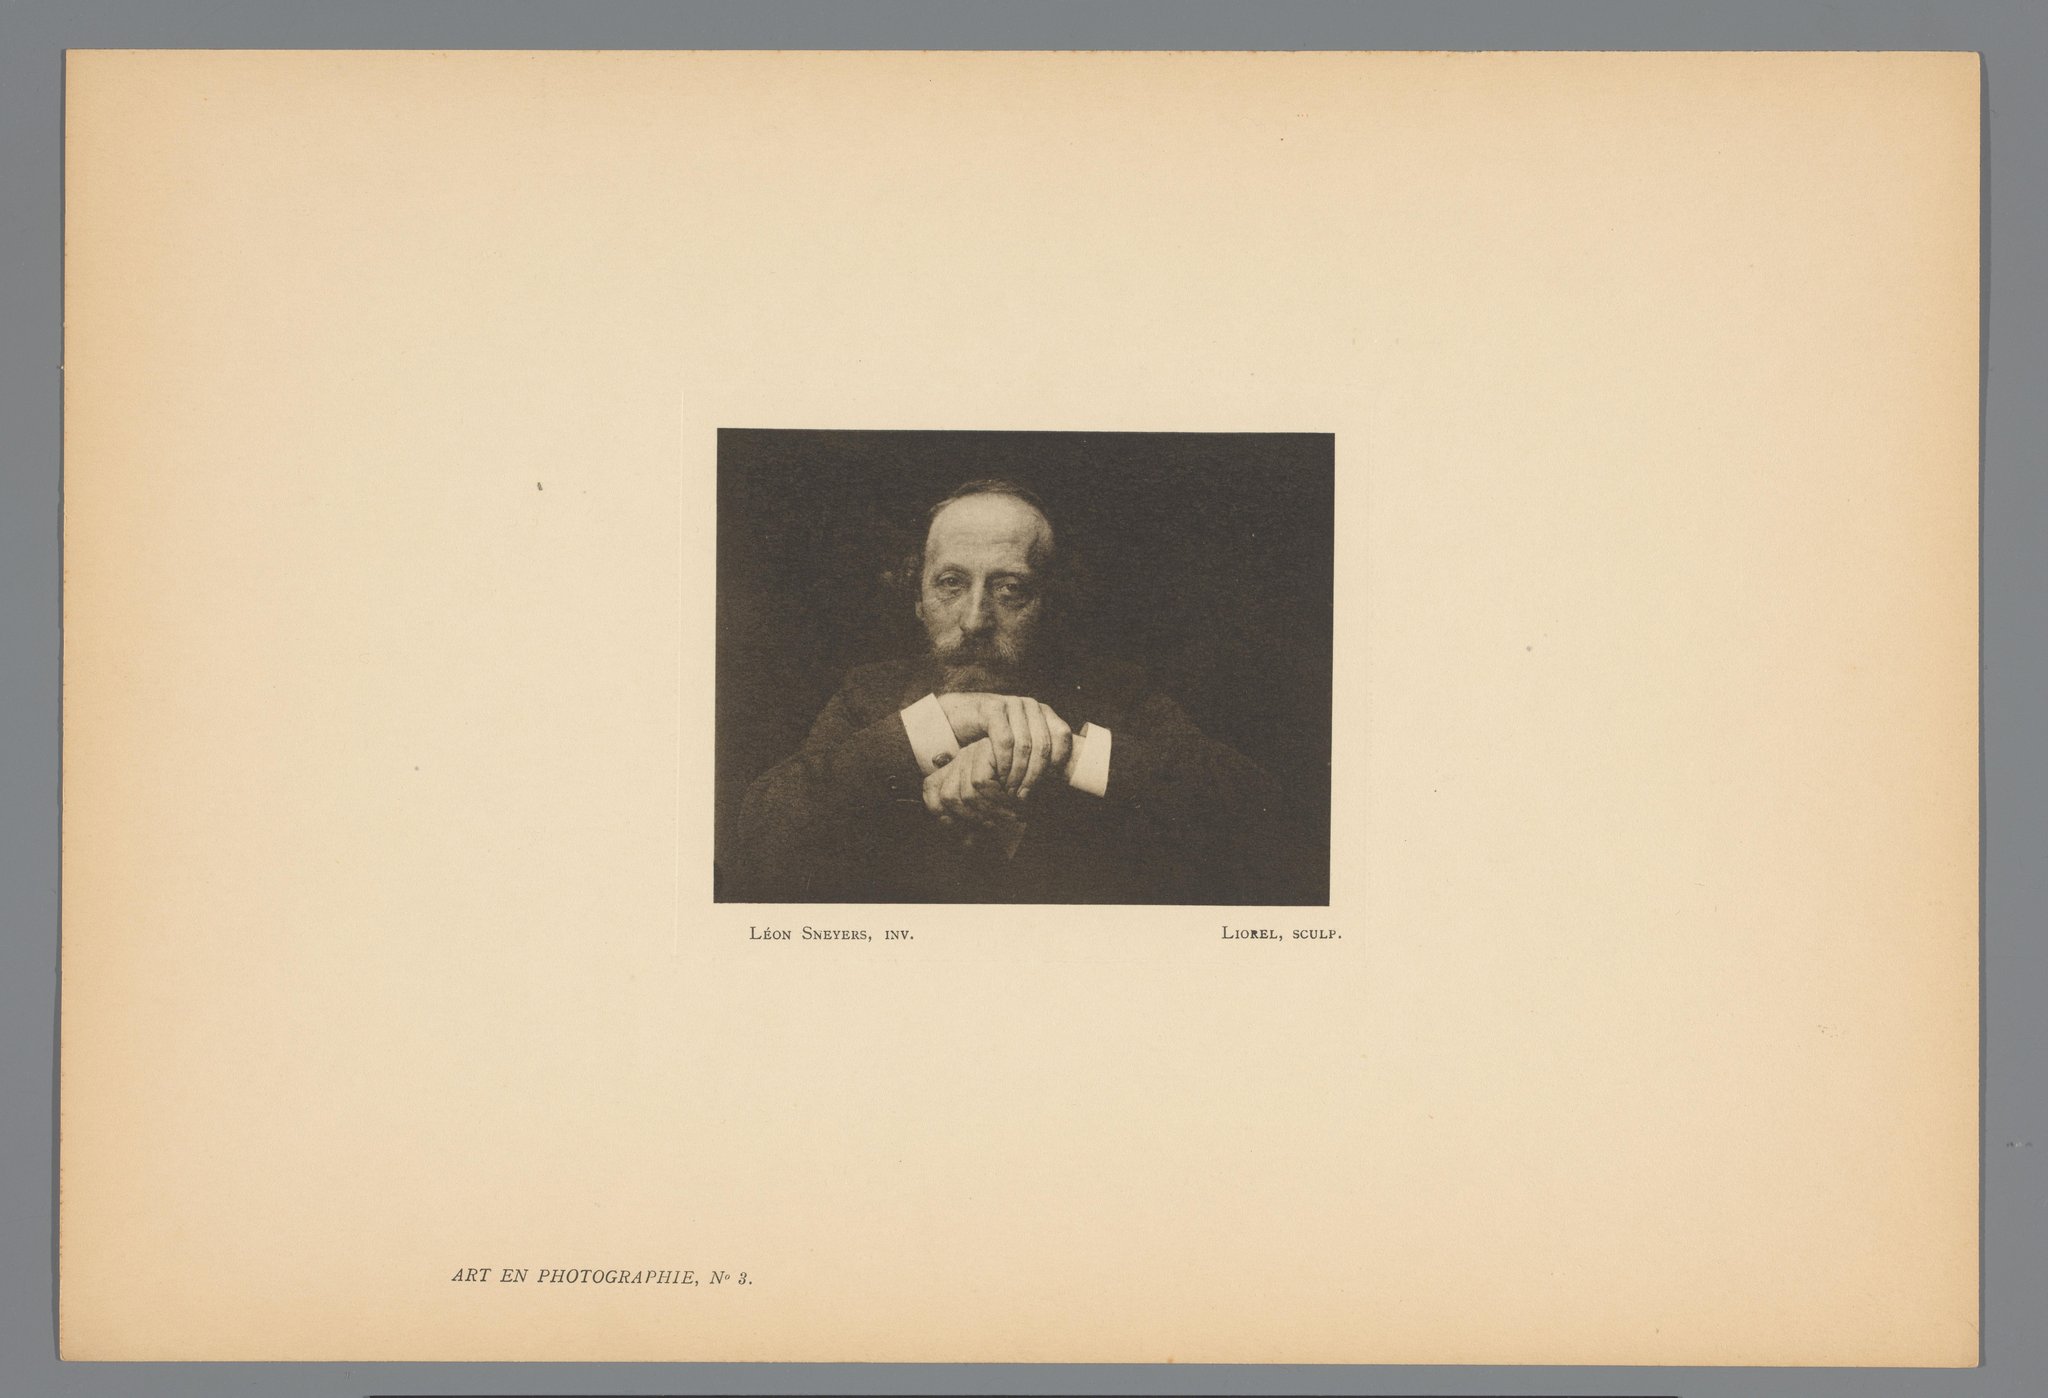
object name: photomechanical print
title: Portret van een onbekende man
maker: léon sneyers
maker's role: architect, fotograaf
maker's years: 1877-1949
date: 1896-1901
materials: paper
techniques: photograph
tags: historical persons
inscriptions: inscription: ‘ART EN PHOTOGRAPHIE, No 3.’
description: Deze prent maakt deel uit van een omslag met 54 prenten op 52 bladen.